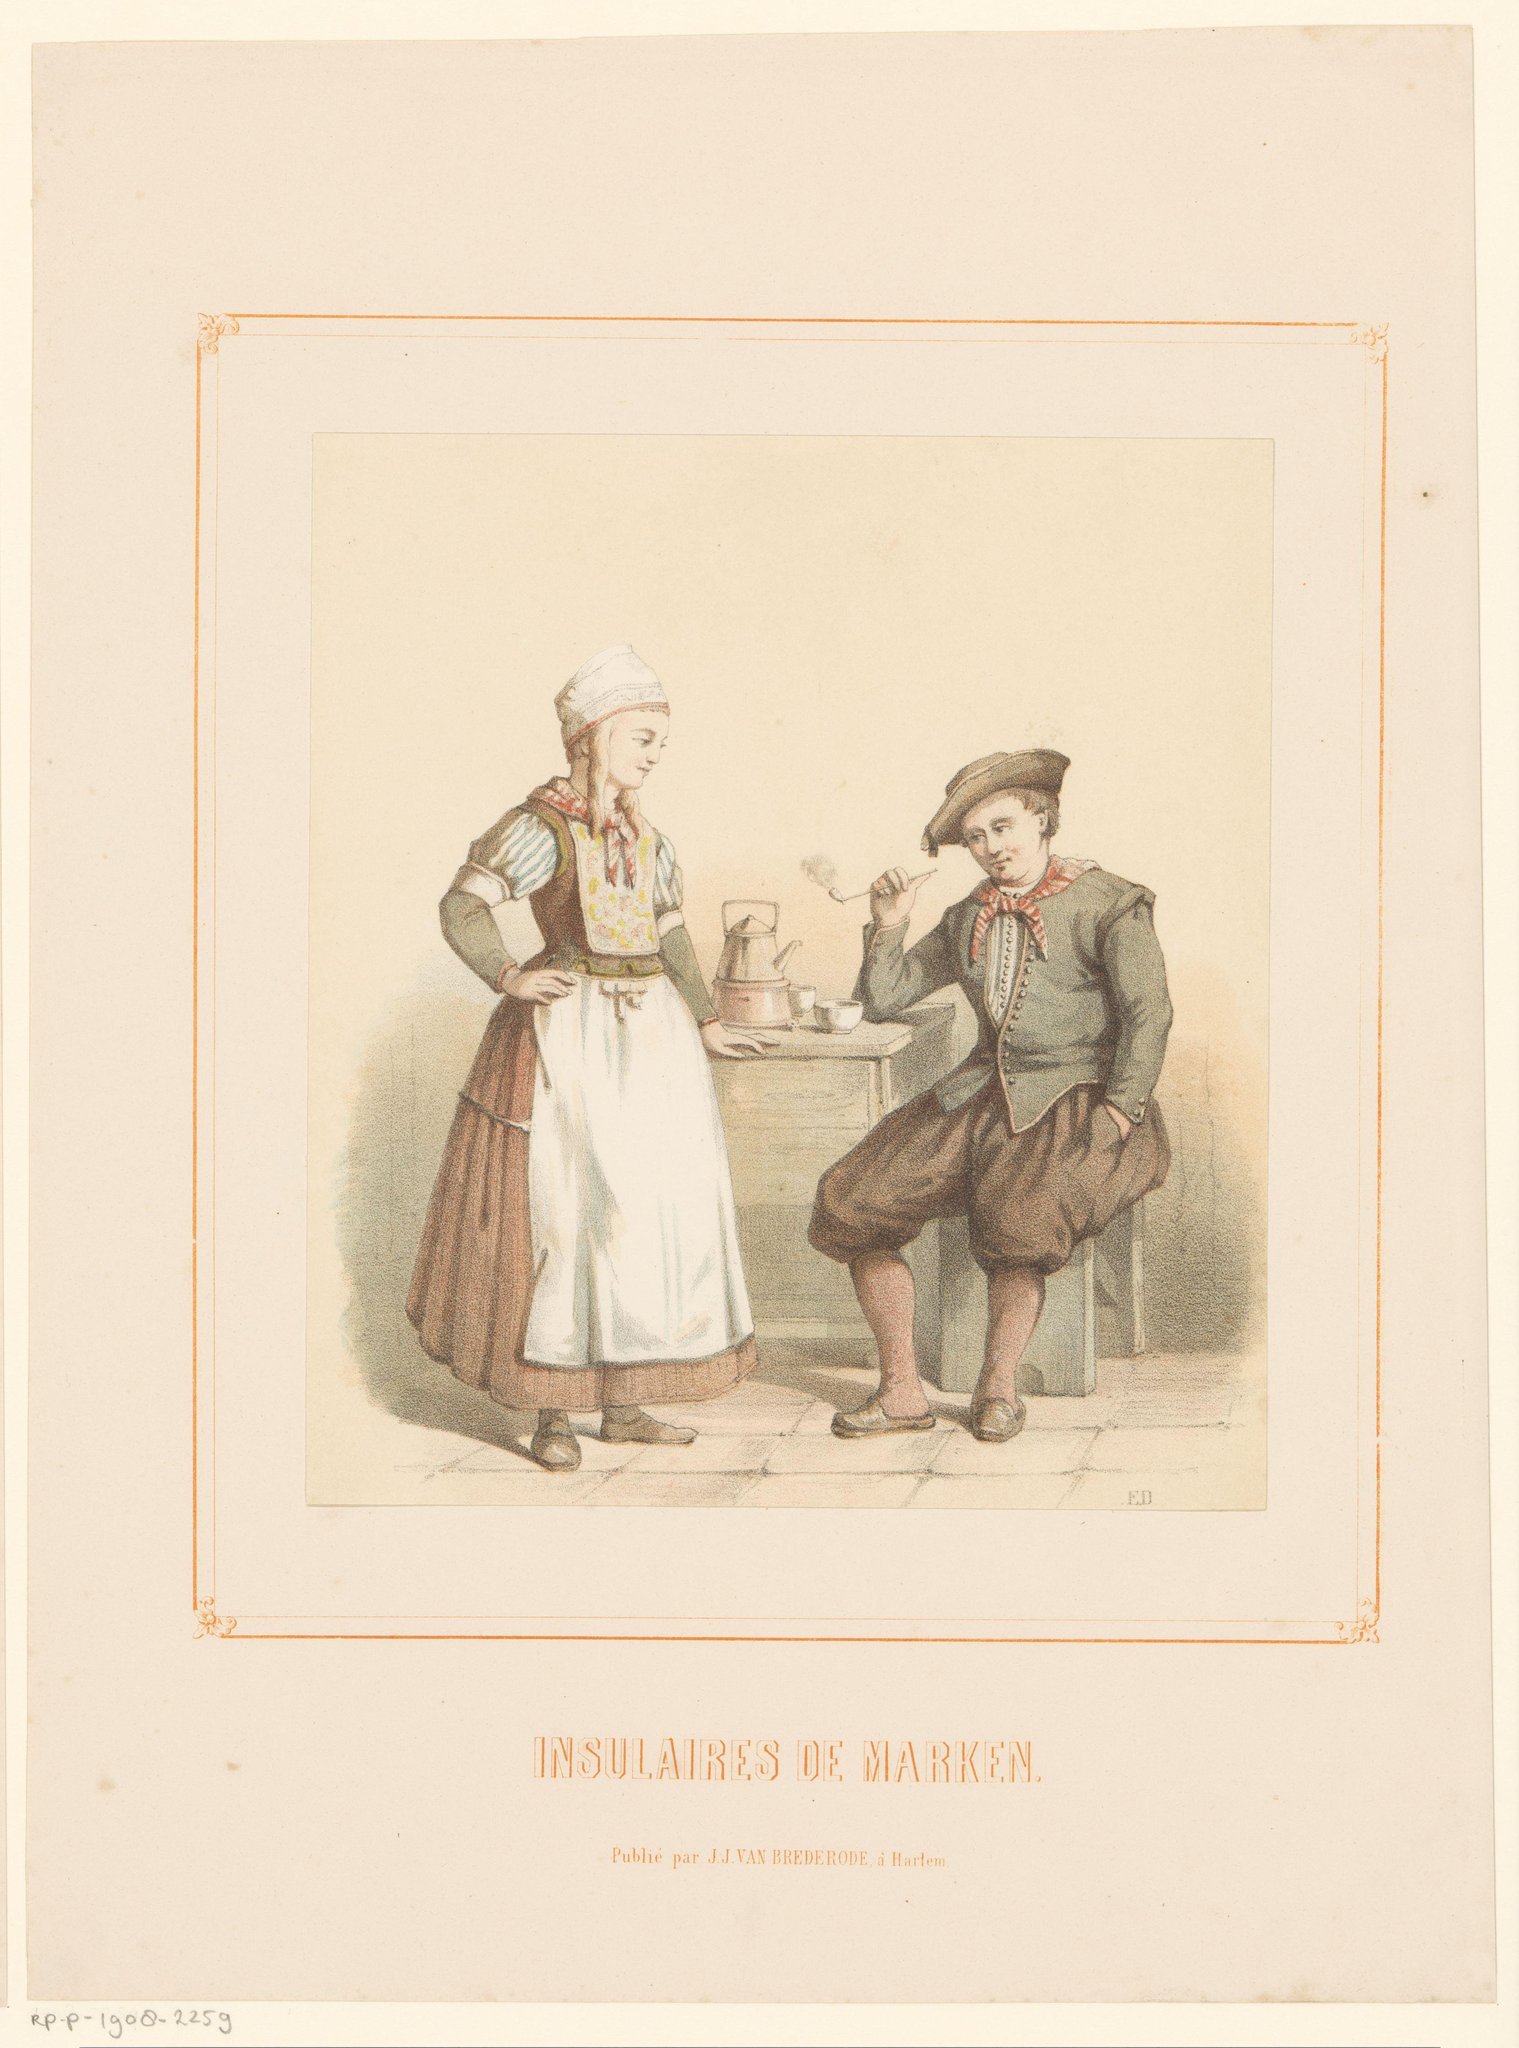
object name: print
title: Twee inwoners van Marken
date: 1849-1873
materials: paper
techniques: lithograph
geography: haarlem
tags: pipe ~ tobacco, folk costume, regional costume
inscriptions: monogram: ‘E.D.’, collector's mark: Lugt 2228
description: De man zit aan tafel en rookt een pijp. De vrouw staat naast hem.